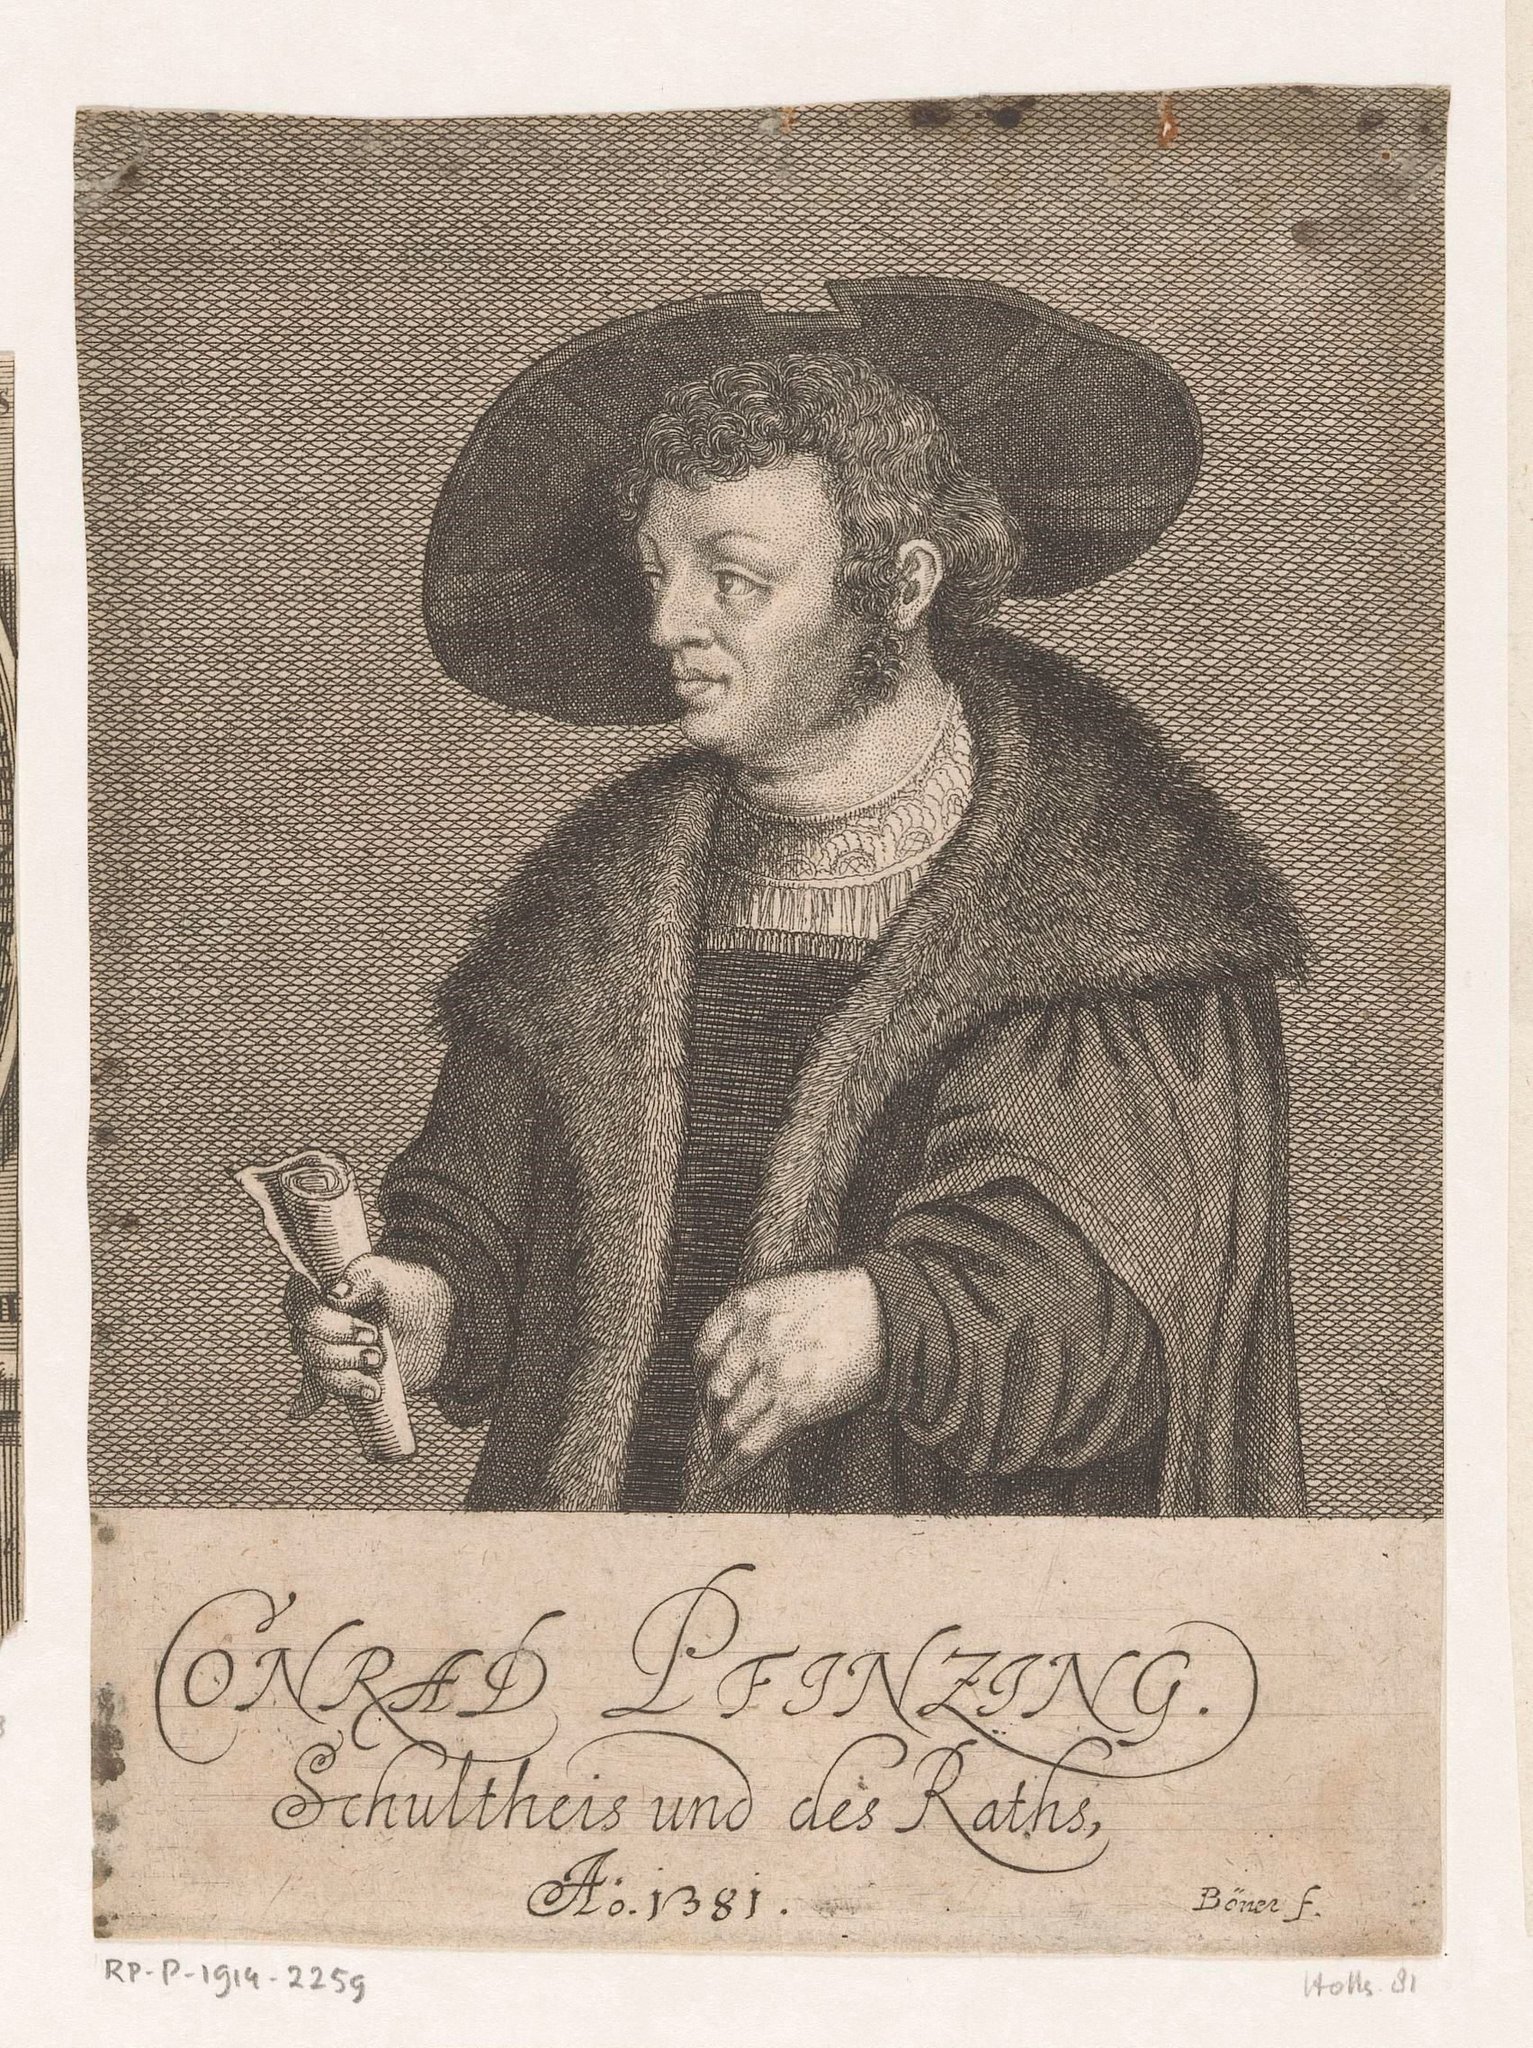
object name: print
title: Portret van Conrad Pfinzing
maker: johann alexander böner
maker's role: draughtsman, print maker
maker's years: 1647-1720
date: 1657-1720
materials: paper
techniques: etching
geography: nuremberg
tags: historical persons, scroll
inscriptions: collector's mark: Lugt 2228